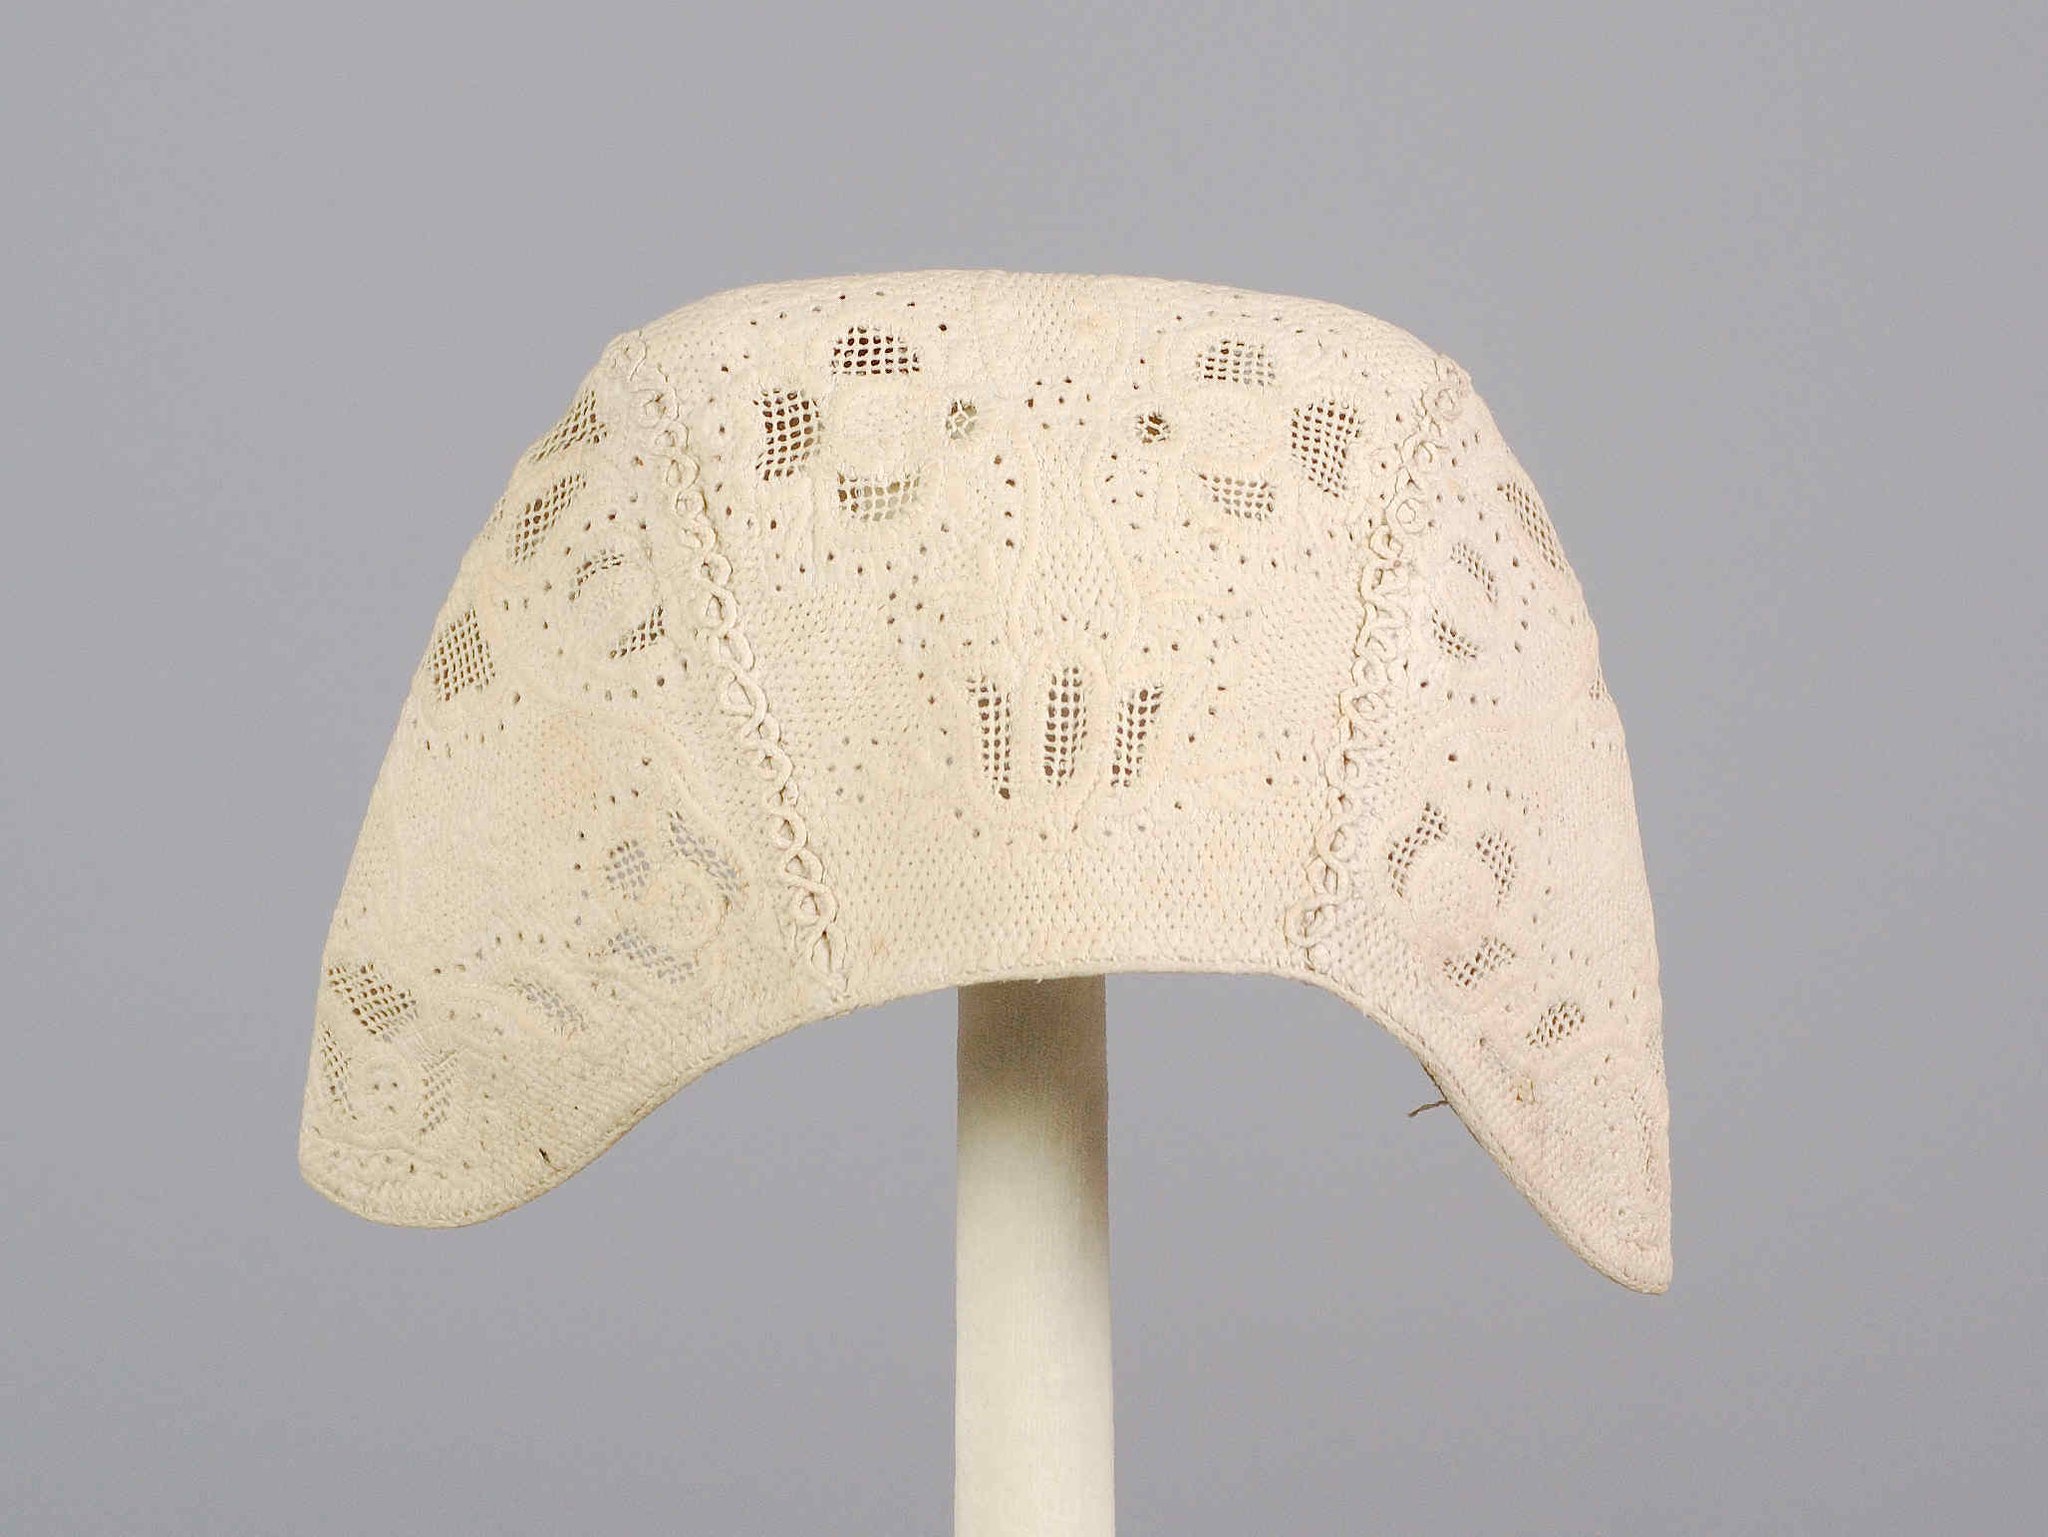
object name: cap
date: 1830-1850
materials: linen